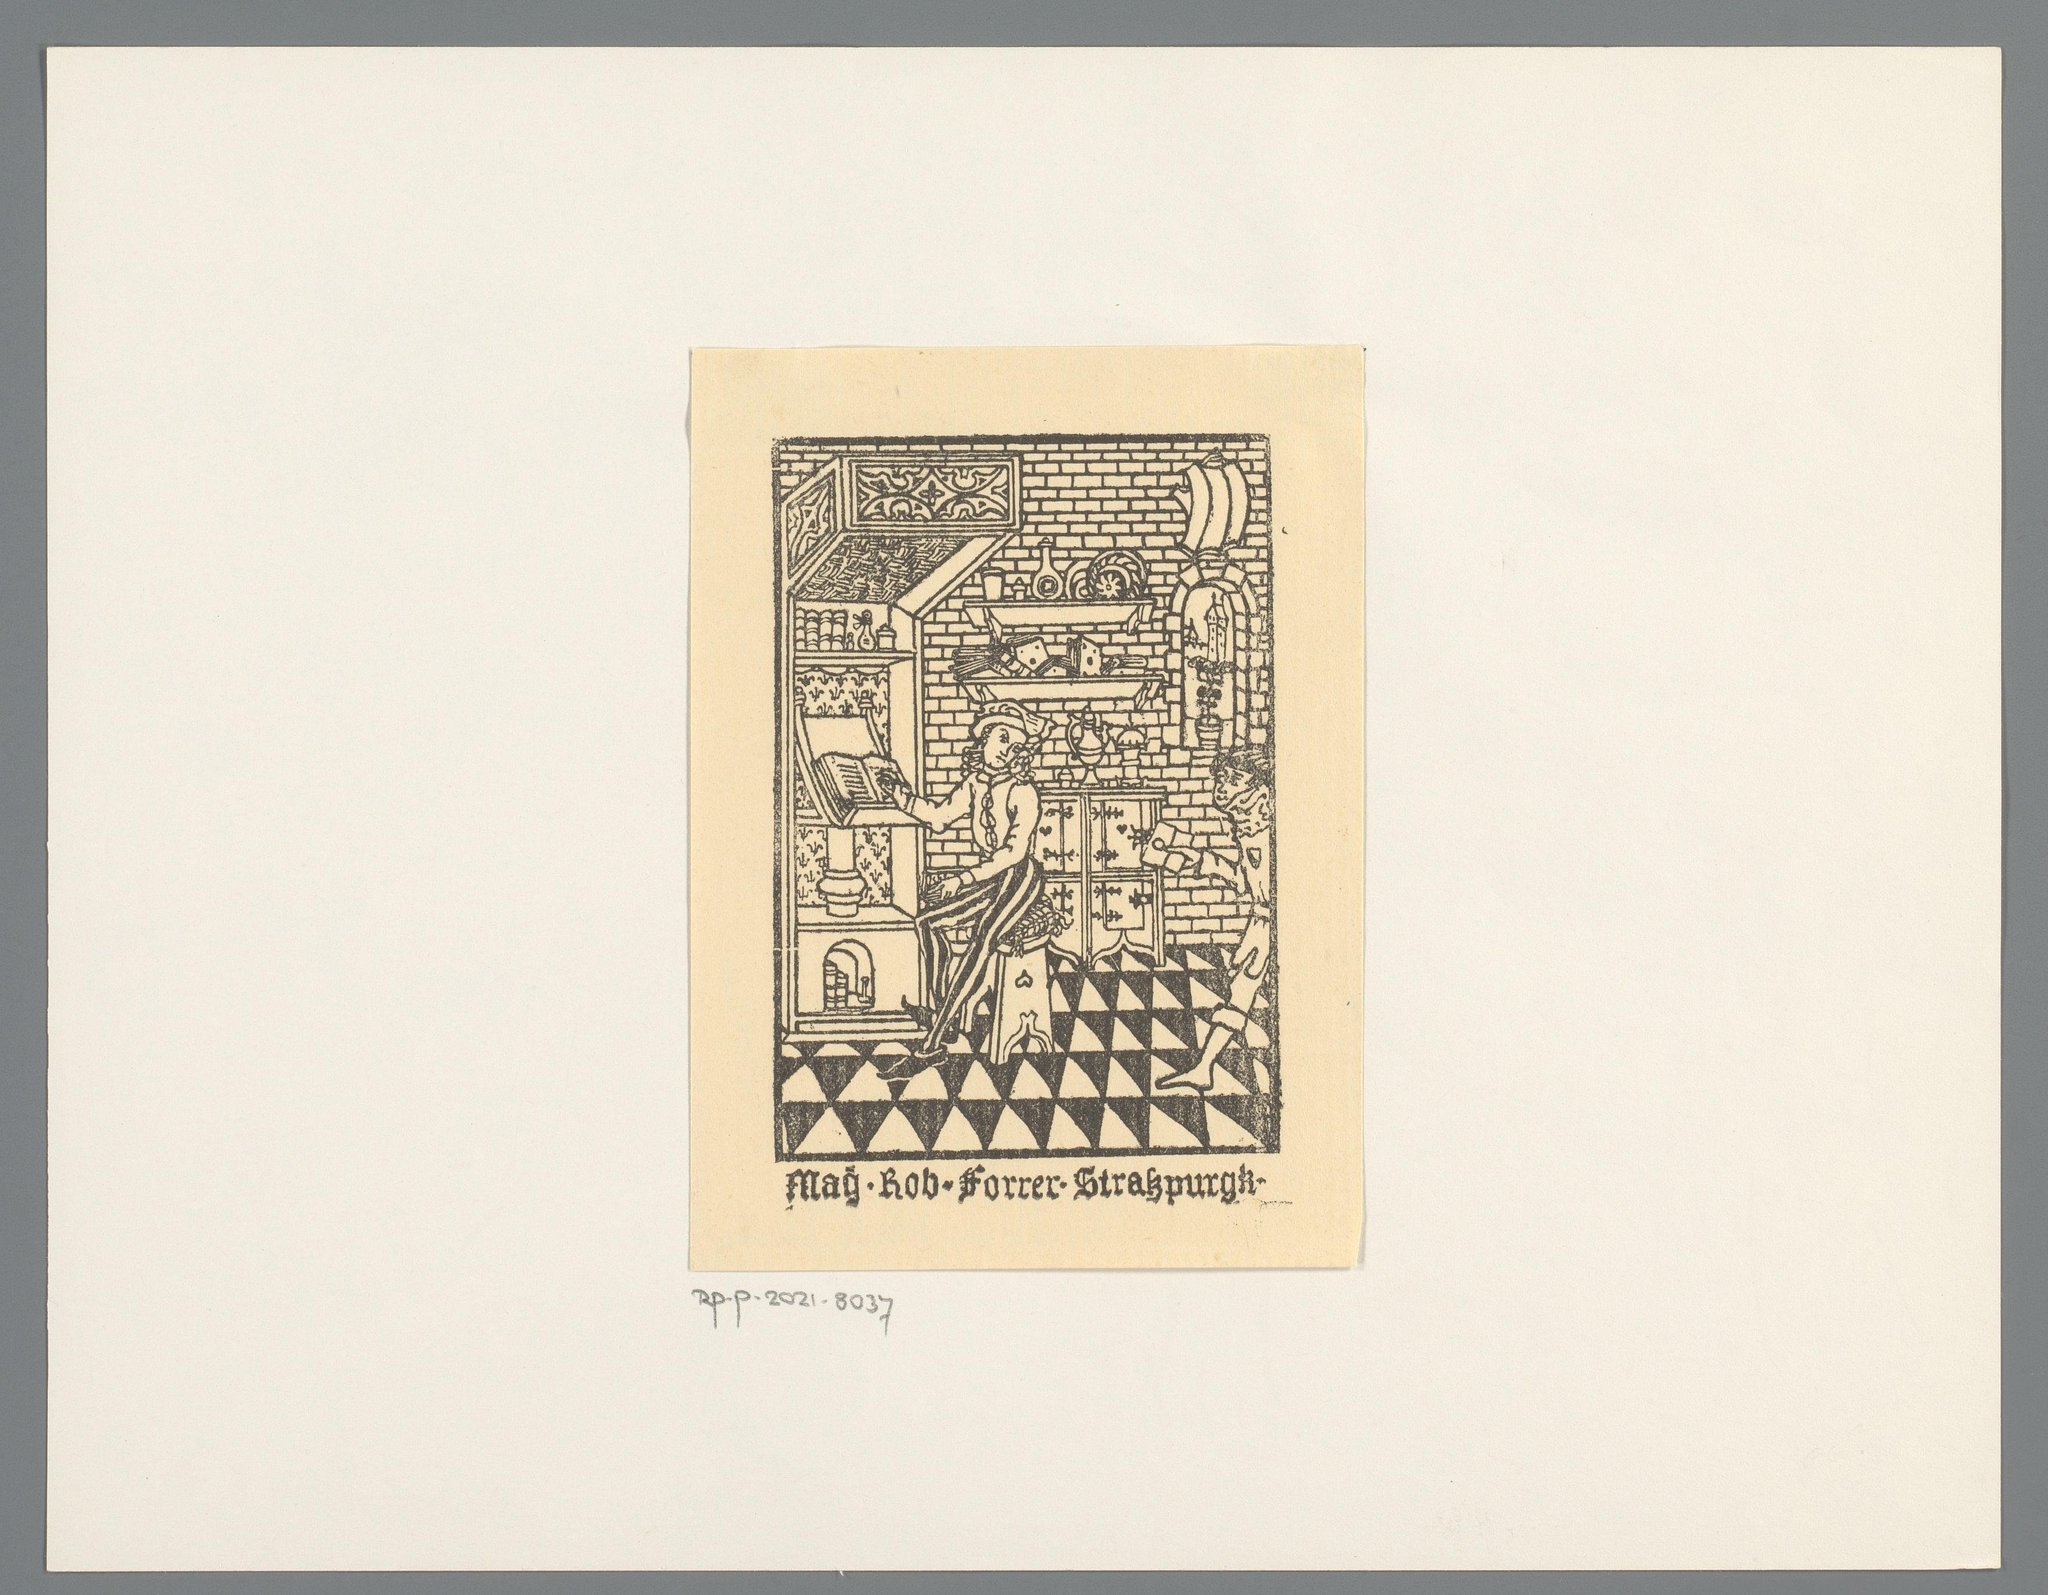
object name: label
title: Etiket van archeoloog en antiquaar Robert Forrer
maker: Anonymous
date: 1876-1947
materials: paper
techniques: woodcut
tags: switzerland, robert forrer, reading, delivering; receiving (~ postal matter), lectern ~ reading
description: Imitatie van een middeleeuwse boekillustratie. Een bode brengt een brief aan een man aan een boekstandaard. Daaronder: 'Mag. Rob Forrer Strasspurgk'.